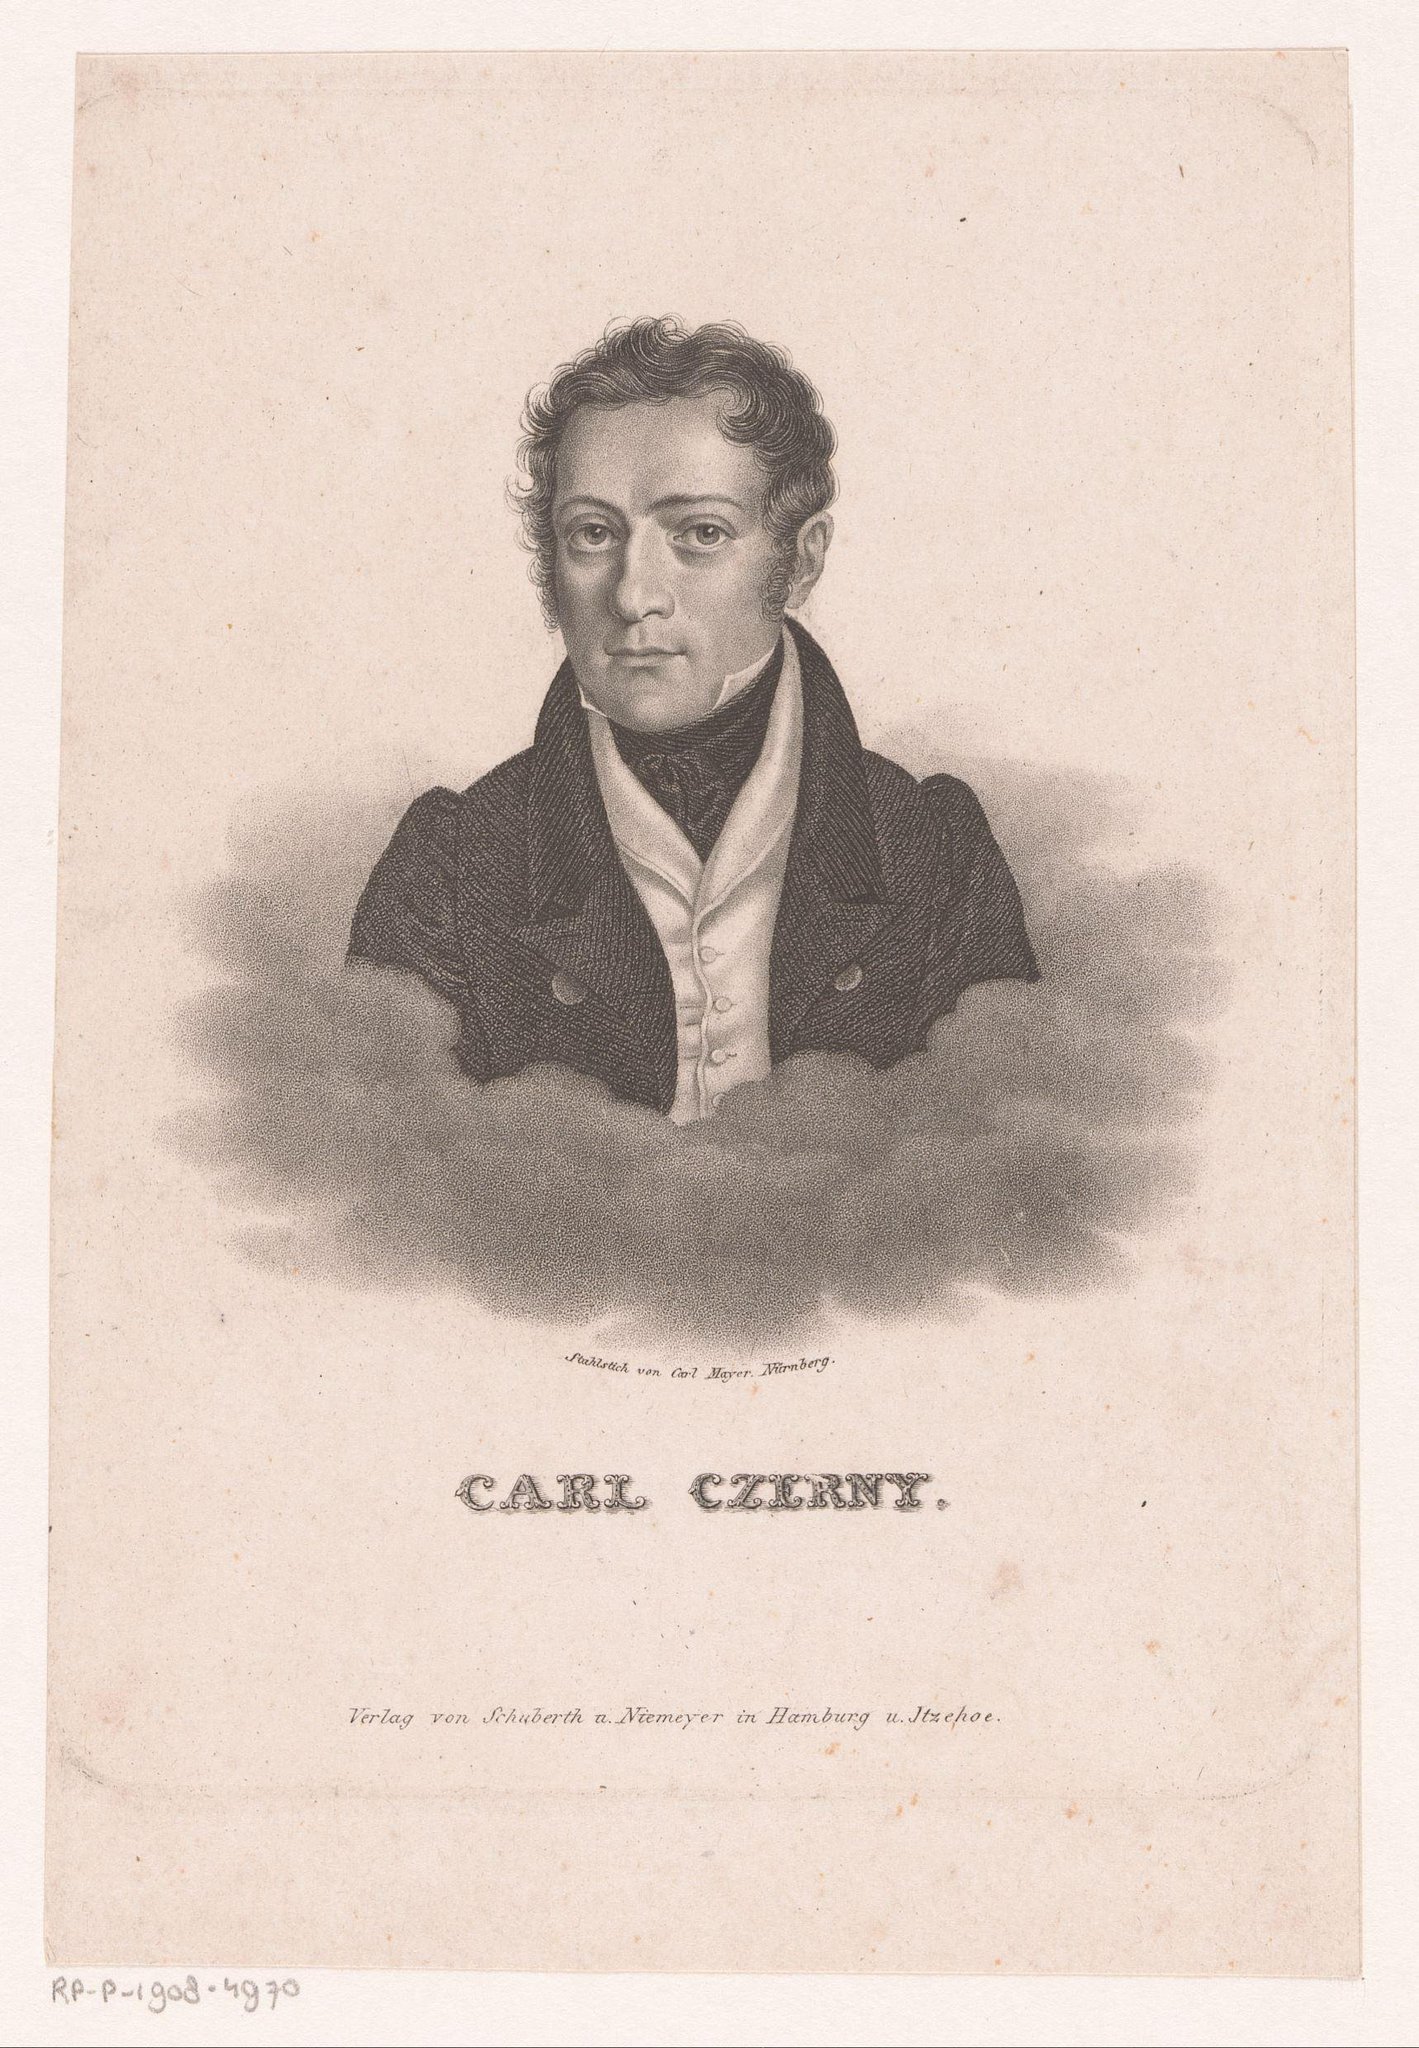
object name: print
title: Portret van Carl Czerny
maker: carl mayer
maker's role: print maker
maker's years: 1798-1868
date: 1808-1868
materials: paper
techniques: engraving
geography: itzehoe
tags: historical persons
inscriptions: collector's mark: Lugt 2228